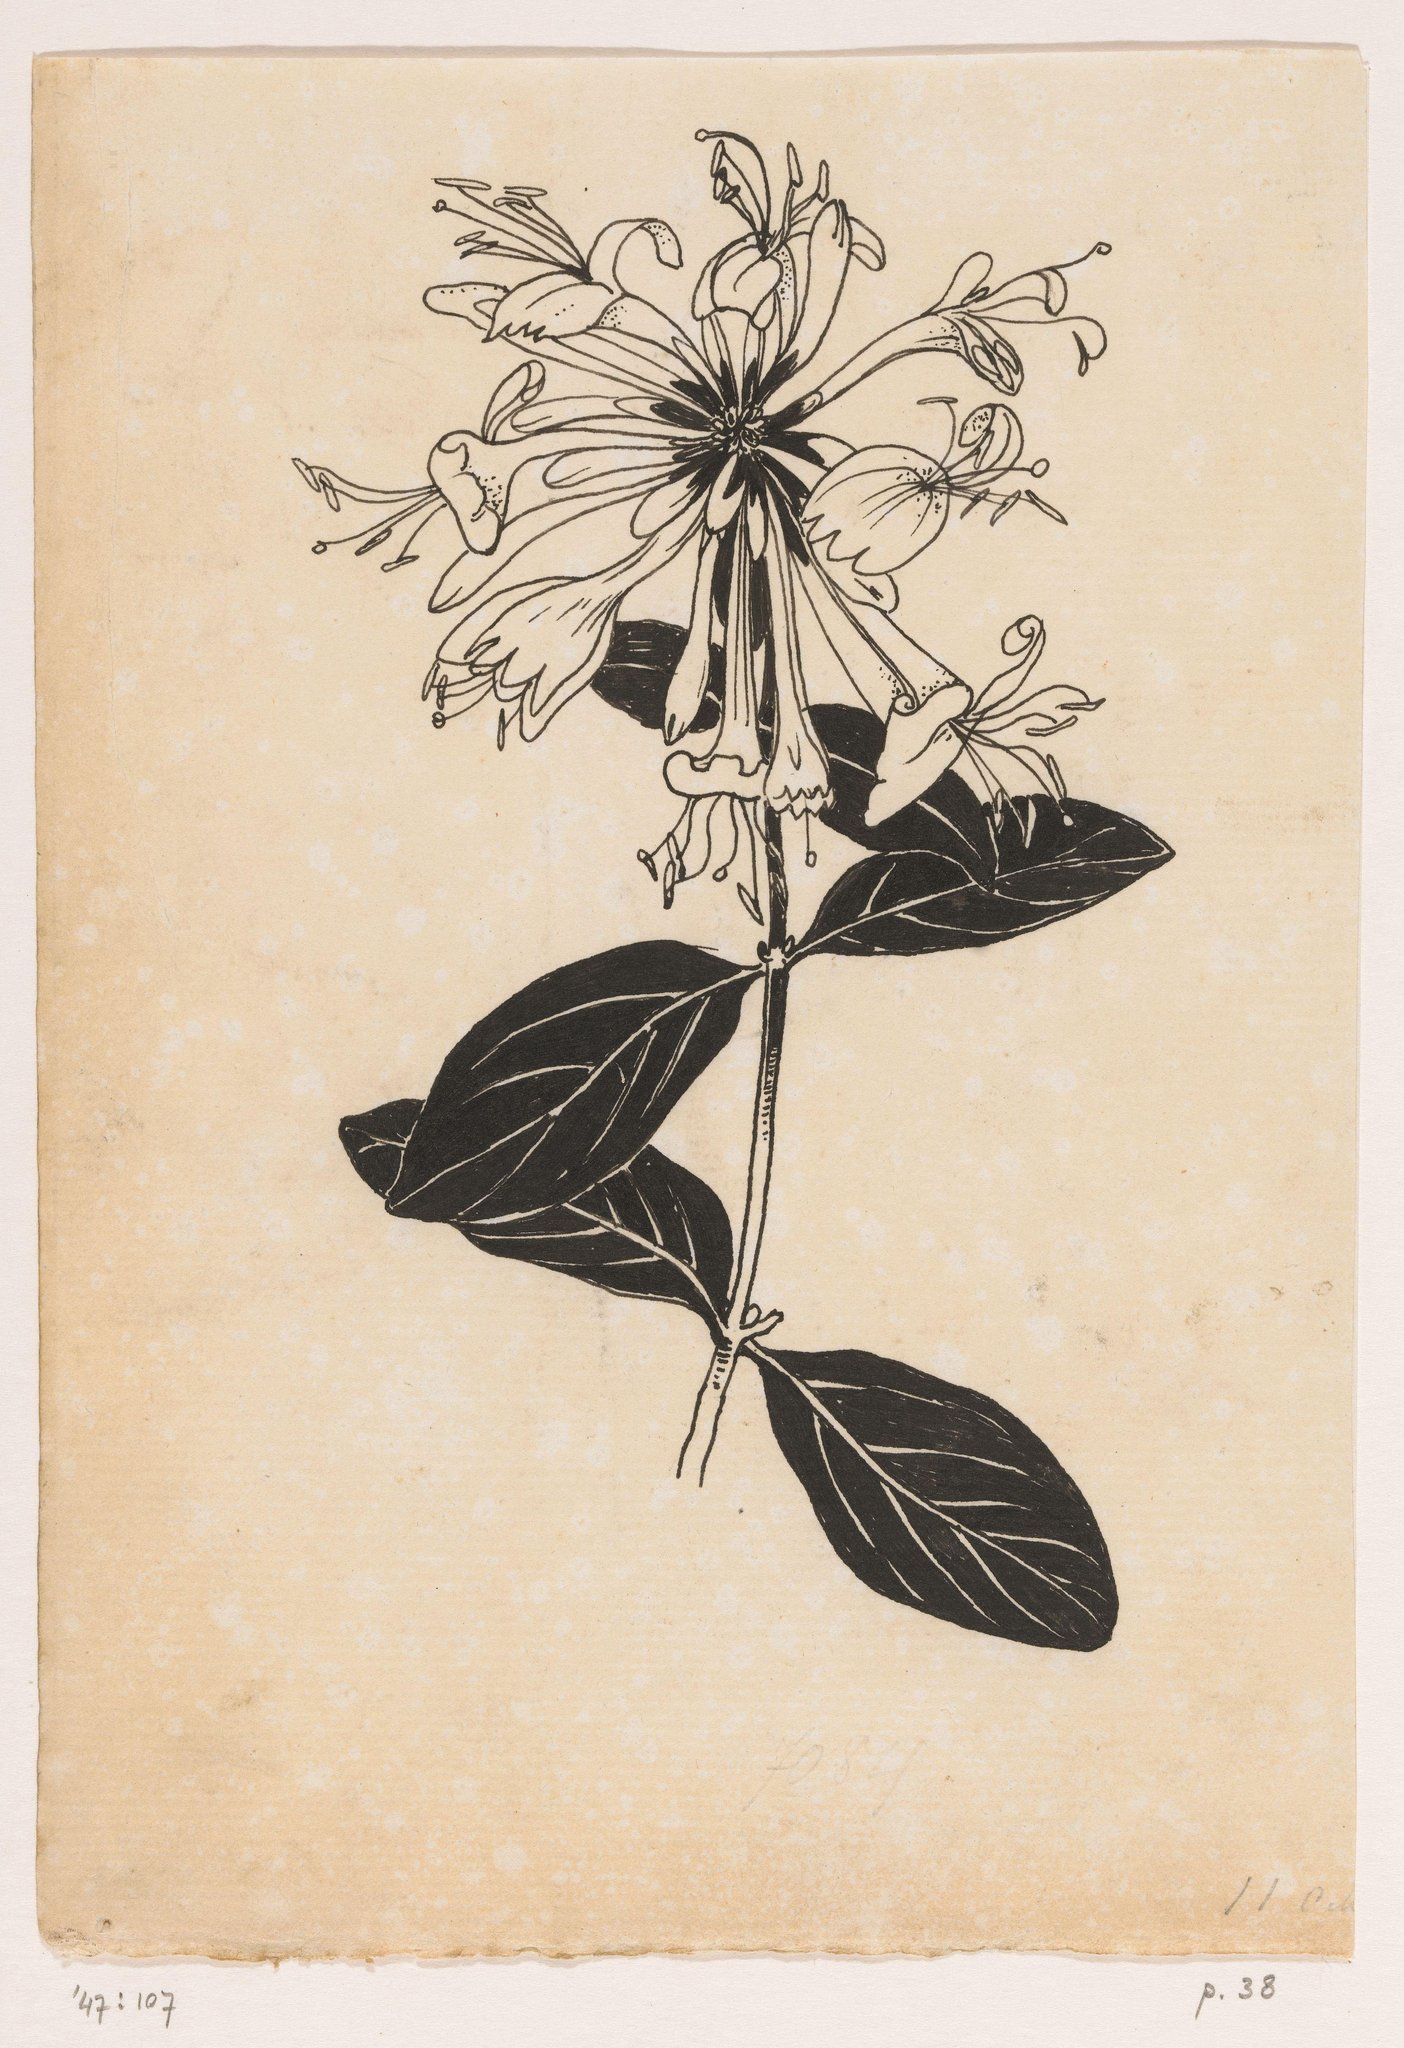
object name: drawing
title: Kamperfoelie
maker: willem wenckebach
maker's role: designer, draughtsman, painter, print maker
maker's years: 1860-1937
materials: ink, paper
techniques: pen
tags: plants (in general)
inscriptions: collector's mark: Lugt 2228a, :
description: Ontwerp voor: Knappert, Emilie C. Kijkjes in de plantenwereld. Loman & Funke: Amsterdam, 1893.